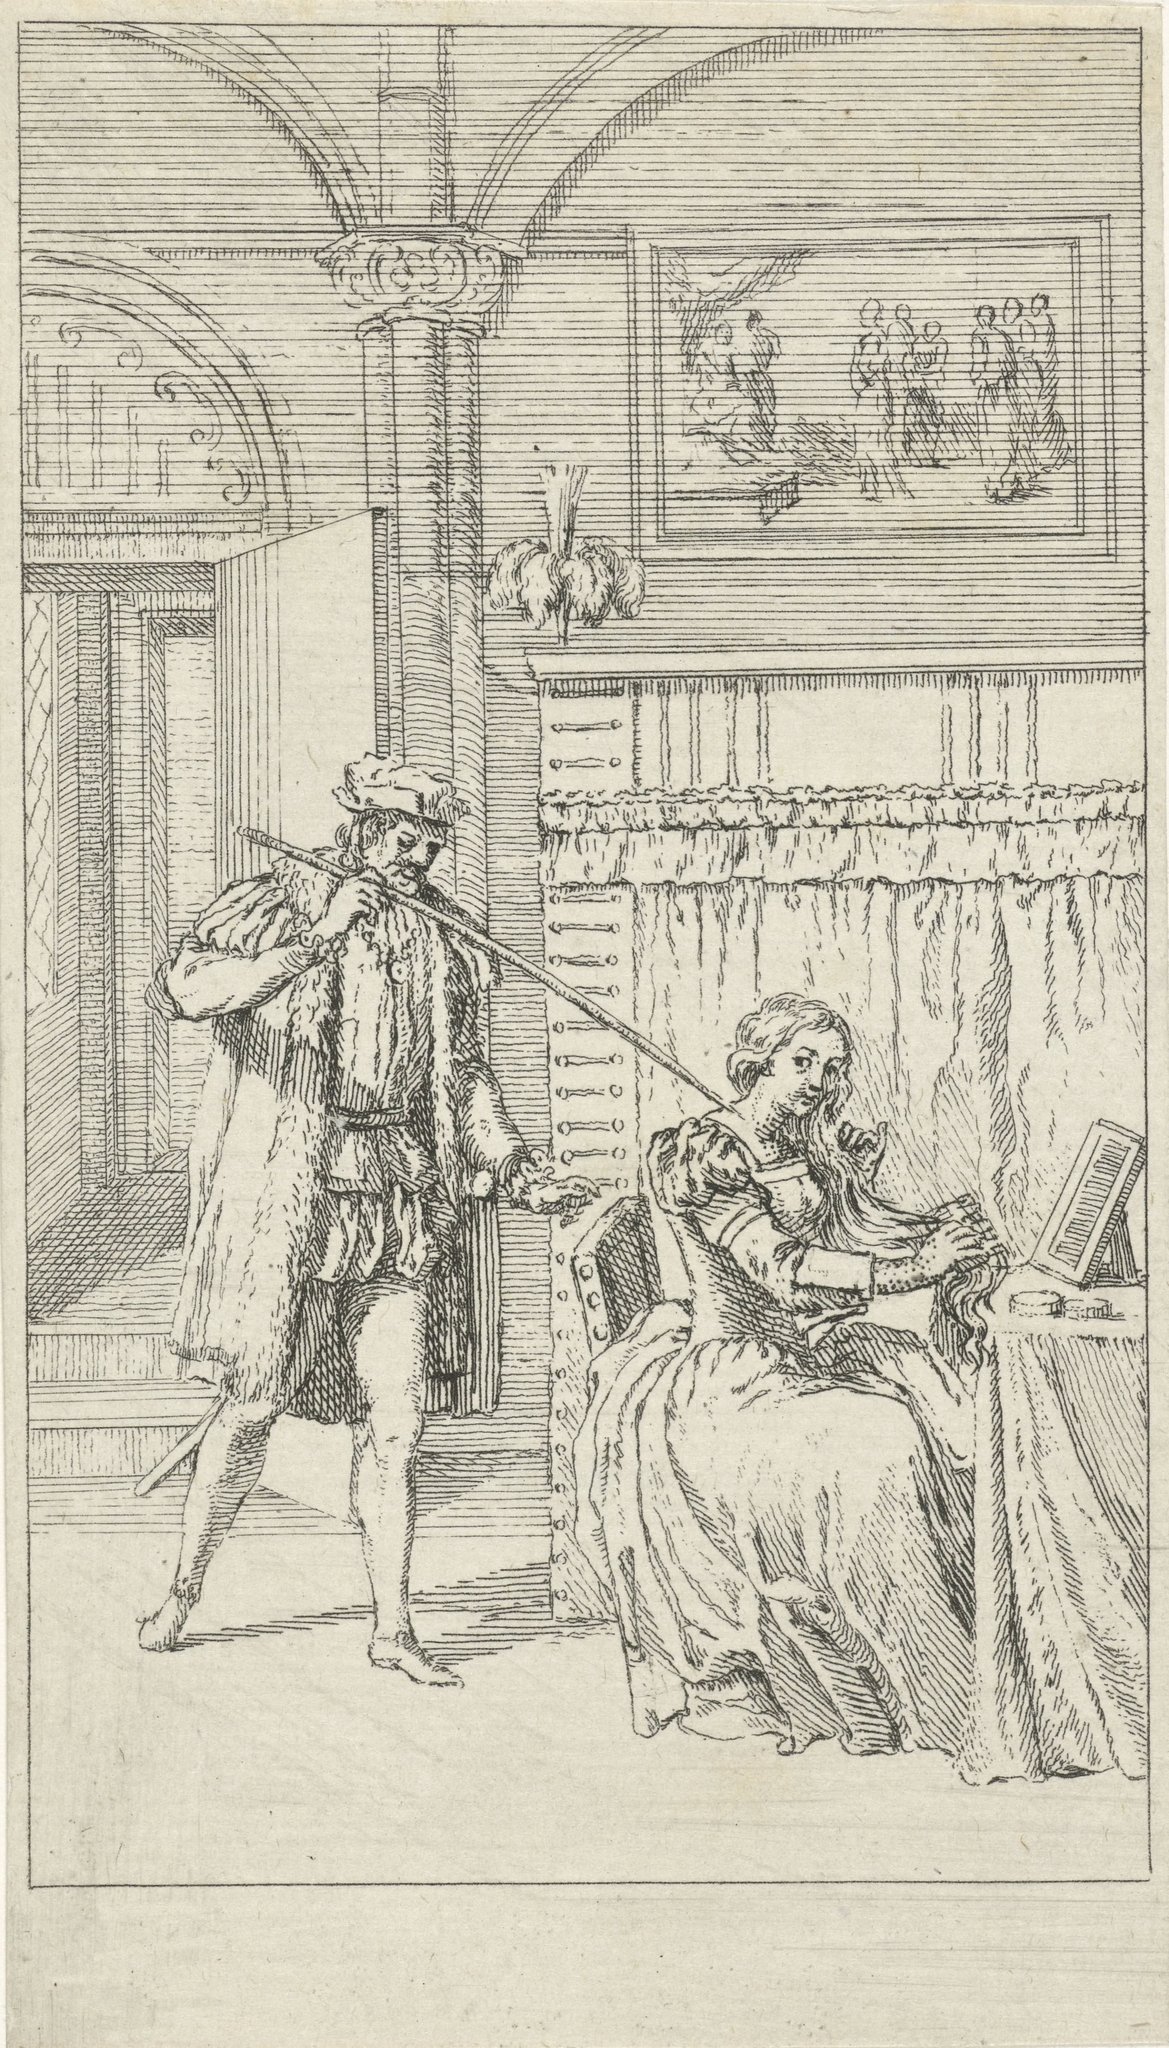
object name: print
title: Chilperik I bezoekt Fredegonde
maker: bernard picart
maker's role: draughtsman, print maker, publisher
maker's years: 1673-1733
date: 1731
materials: paper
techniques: etching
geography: amsterdam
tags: palace - aa - civic architecture: inside, comb, brush and other tools (care of the hair) - aa - ~ women, courting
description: Definitieve staat van deze prent als illustratie gebruikt in: Vanel, Claude, M., Henri Sauval. Galanteries des rois de France: depuis le commencement de la monarchie cenrichie de figures en taille-douce & augmentée des amours des rois de France sous plusieurs races, tirées de l'Histoire de la ville de Paris. Amsterdam: Charles Moette, 1731.